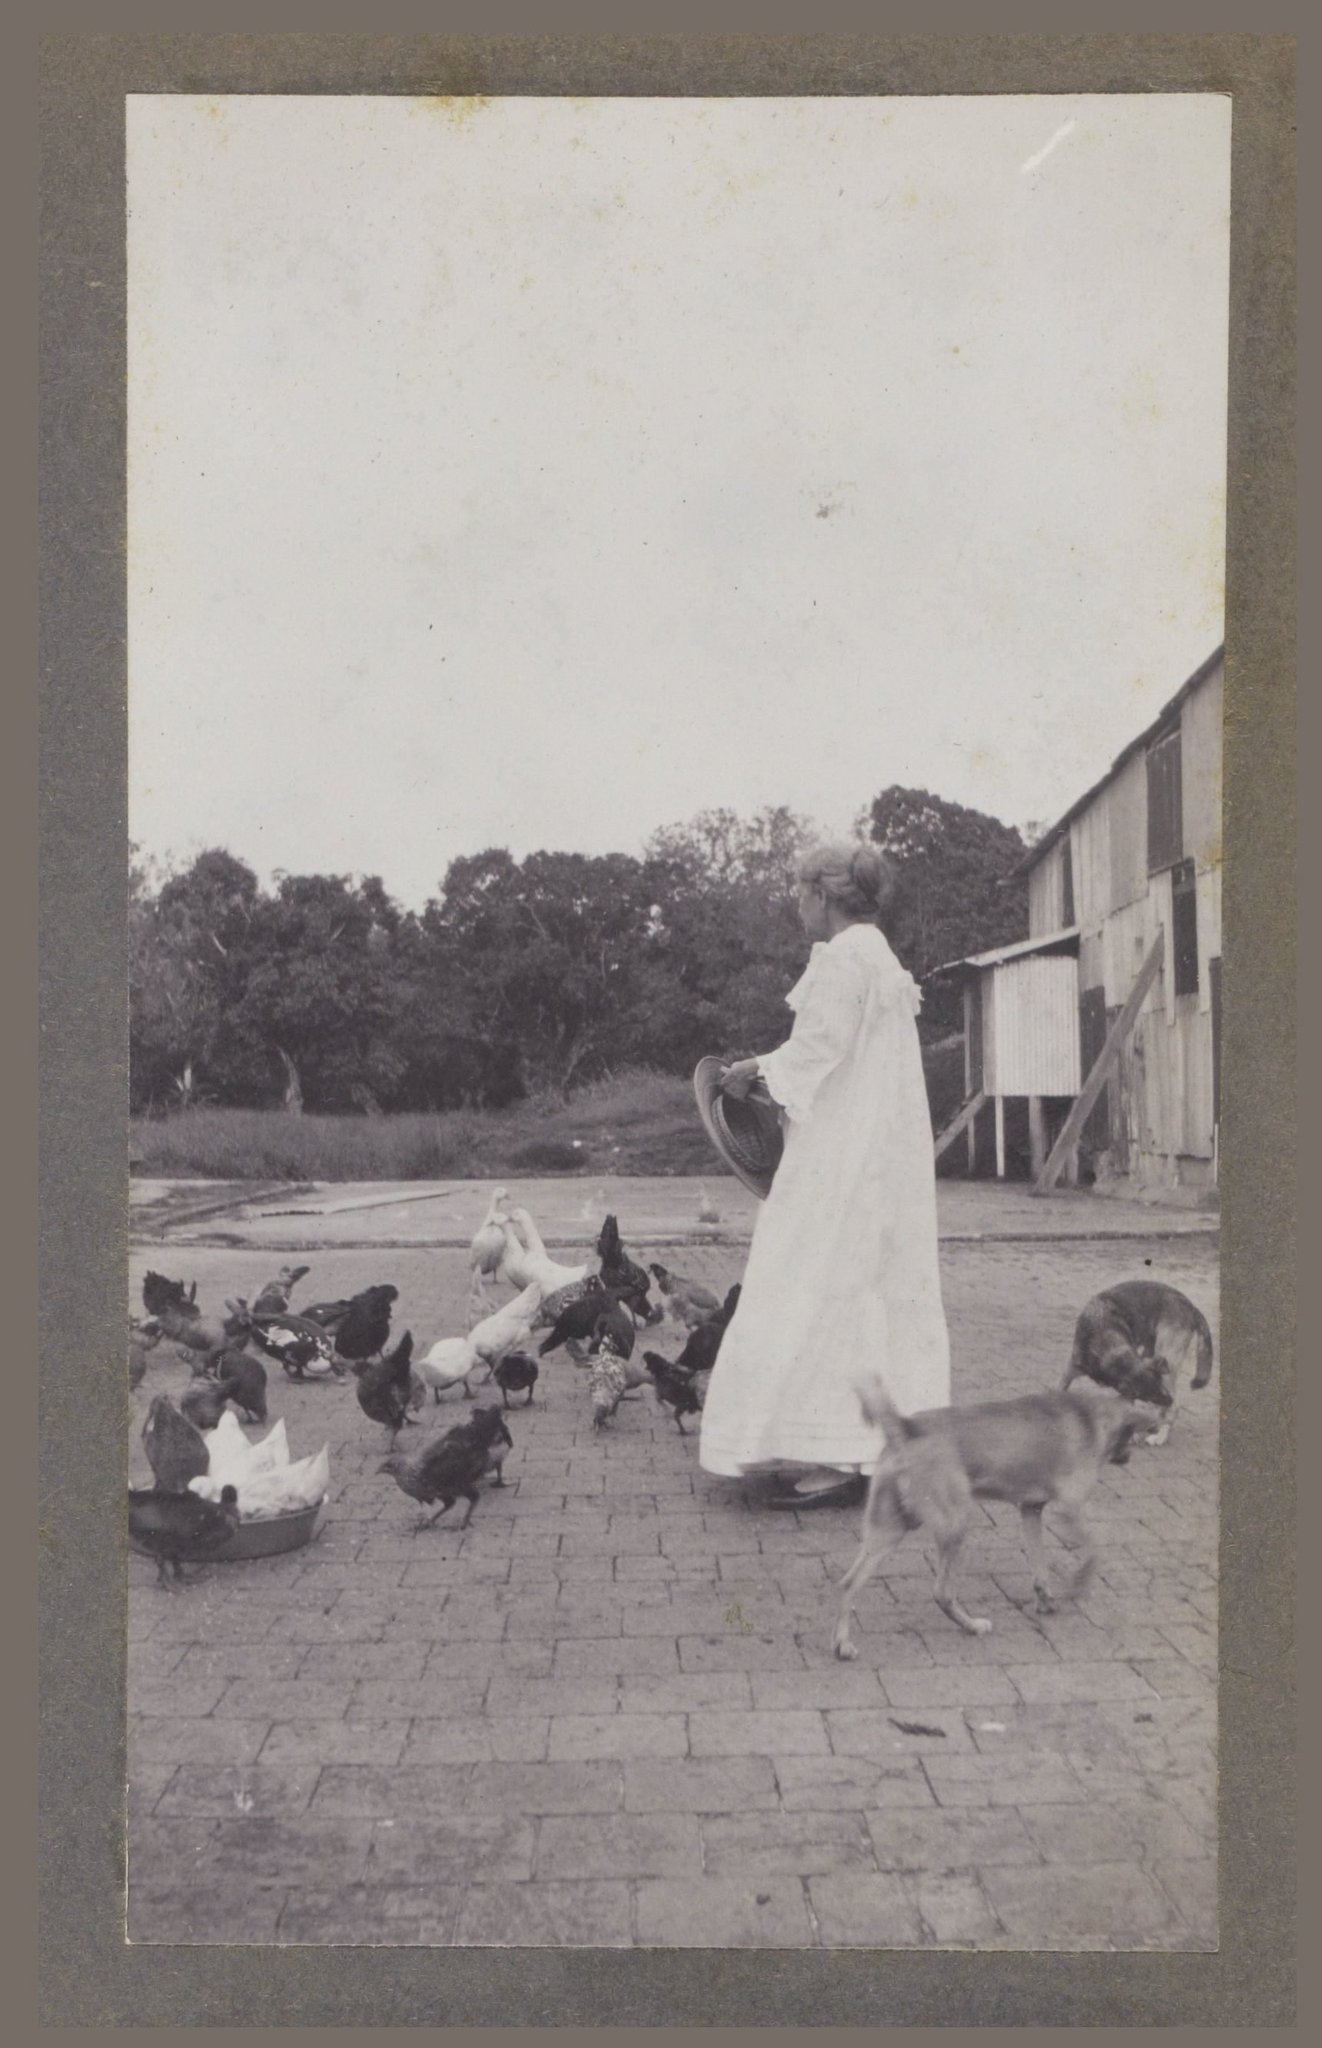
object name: photograph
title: Kippen voeren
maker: Anonymous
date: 1912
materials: photographic support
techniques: photography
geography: suriname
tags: fowl (cock, hen, chicken, etc.), suriname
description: Een oudere vrouw voert de kippen op een stenen terras. Onderdeel van het fotoalbum over het leven van de familie Gonggrijp in Suriname rond 1912.